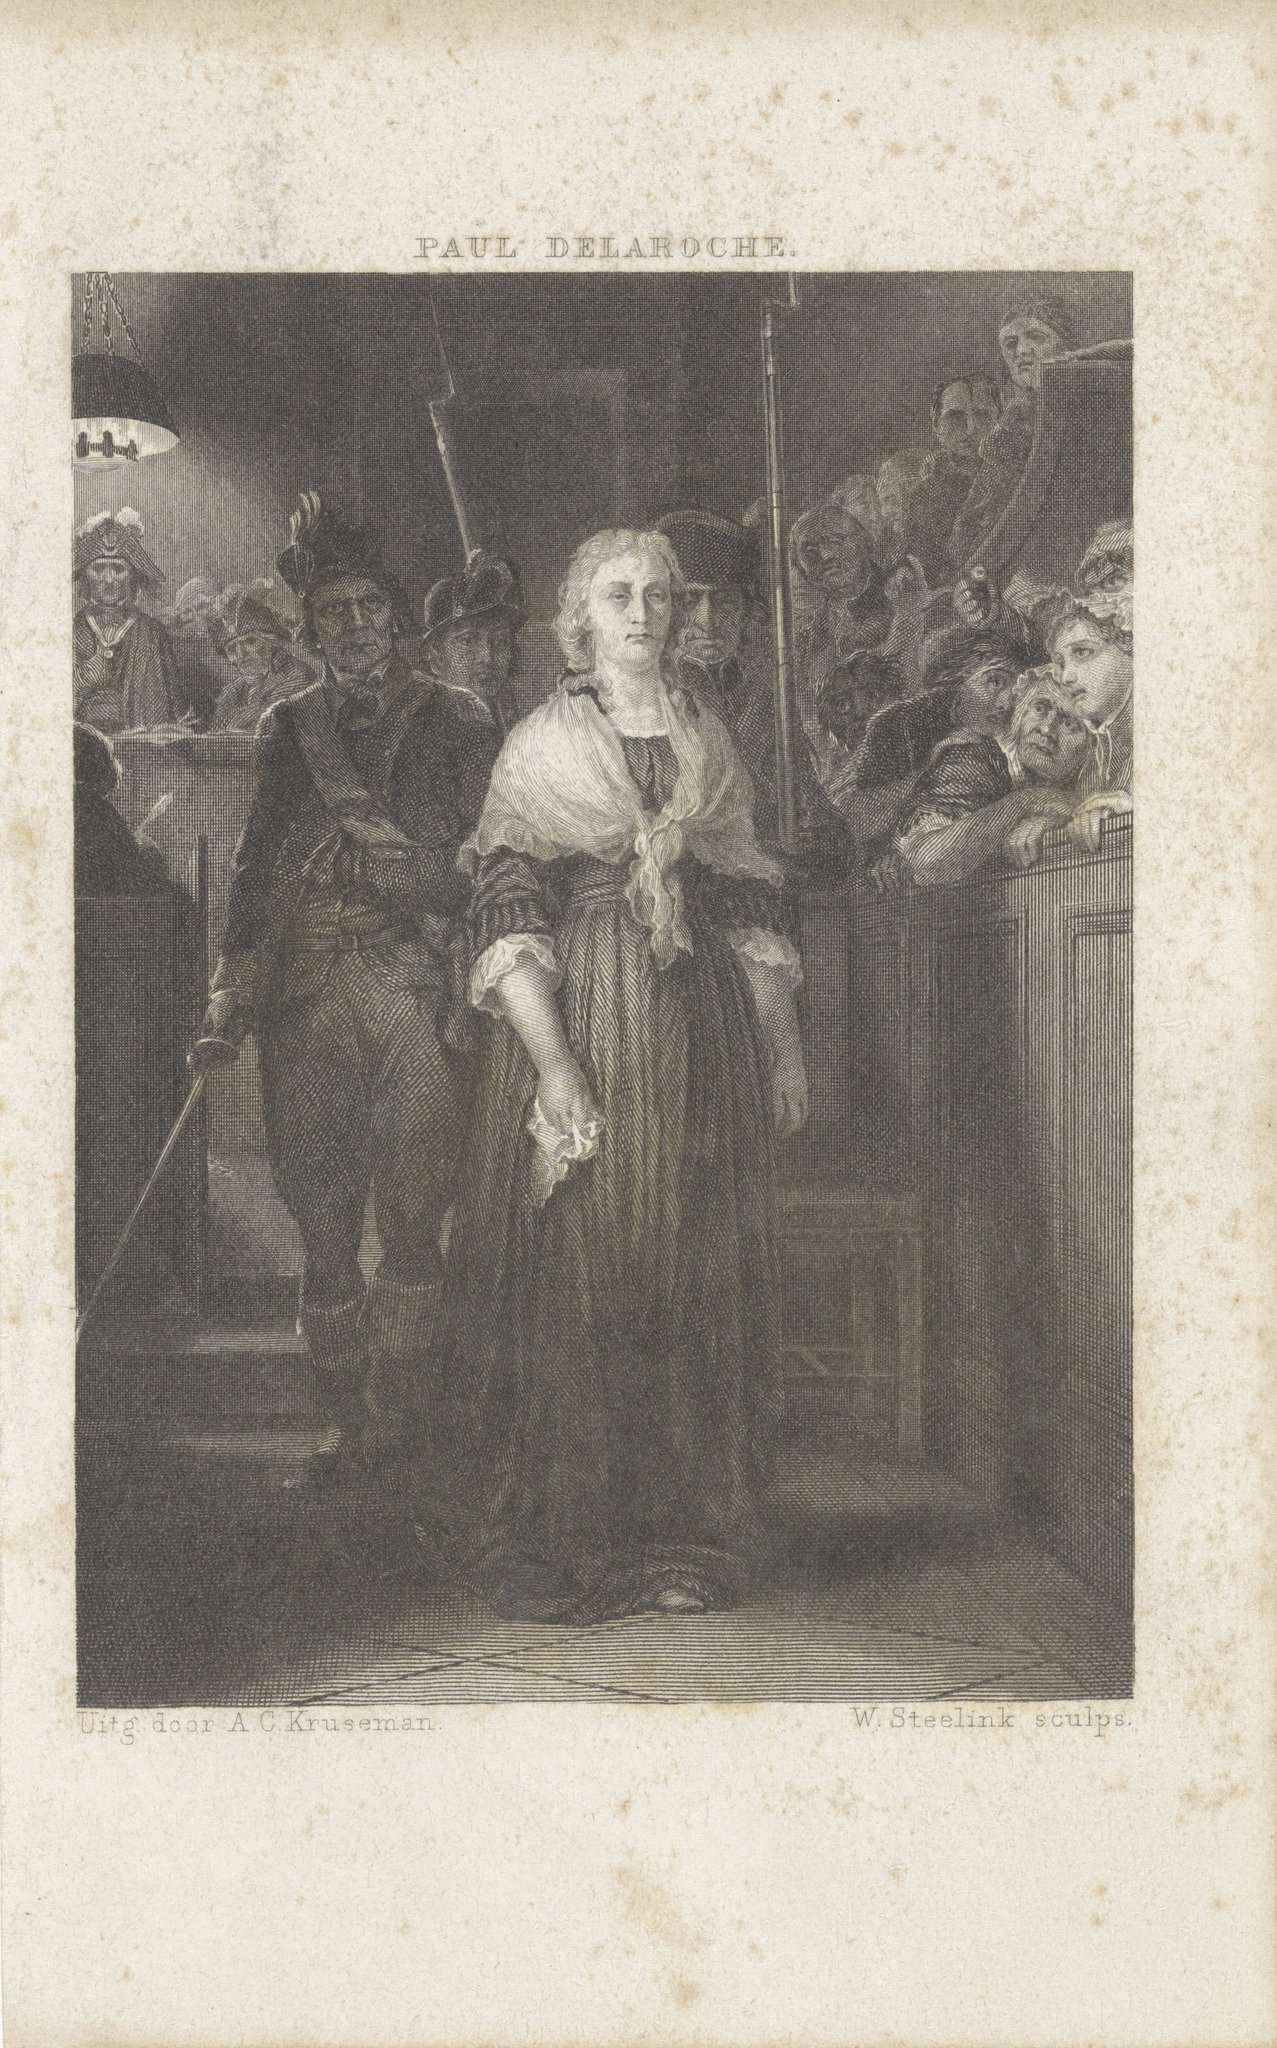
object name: print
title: Marie Antoinette voor het revolutionaire tribunaal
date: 1860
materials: paper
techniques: etching, engraving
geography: haarlem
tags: vienna, paris, marie antoinette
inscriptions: collector's mark: Lugt 2228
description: Illustratie voor: Aurora. Jaarboekje voor 1860. Haarlem: Arie Cornelis Kruseman, 1860.